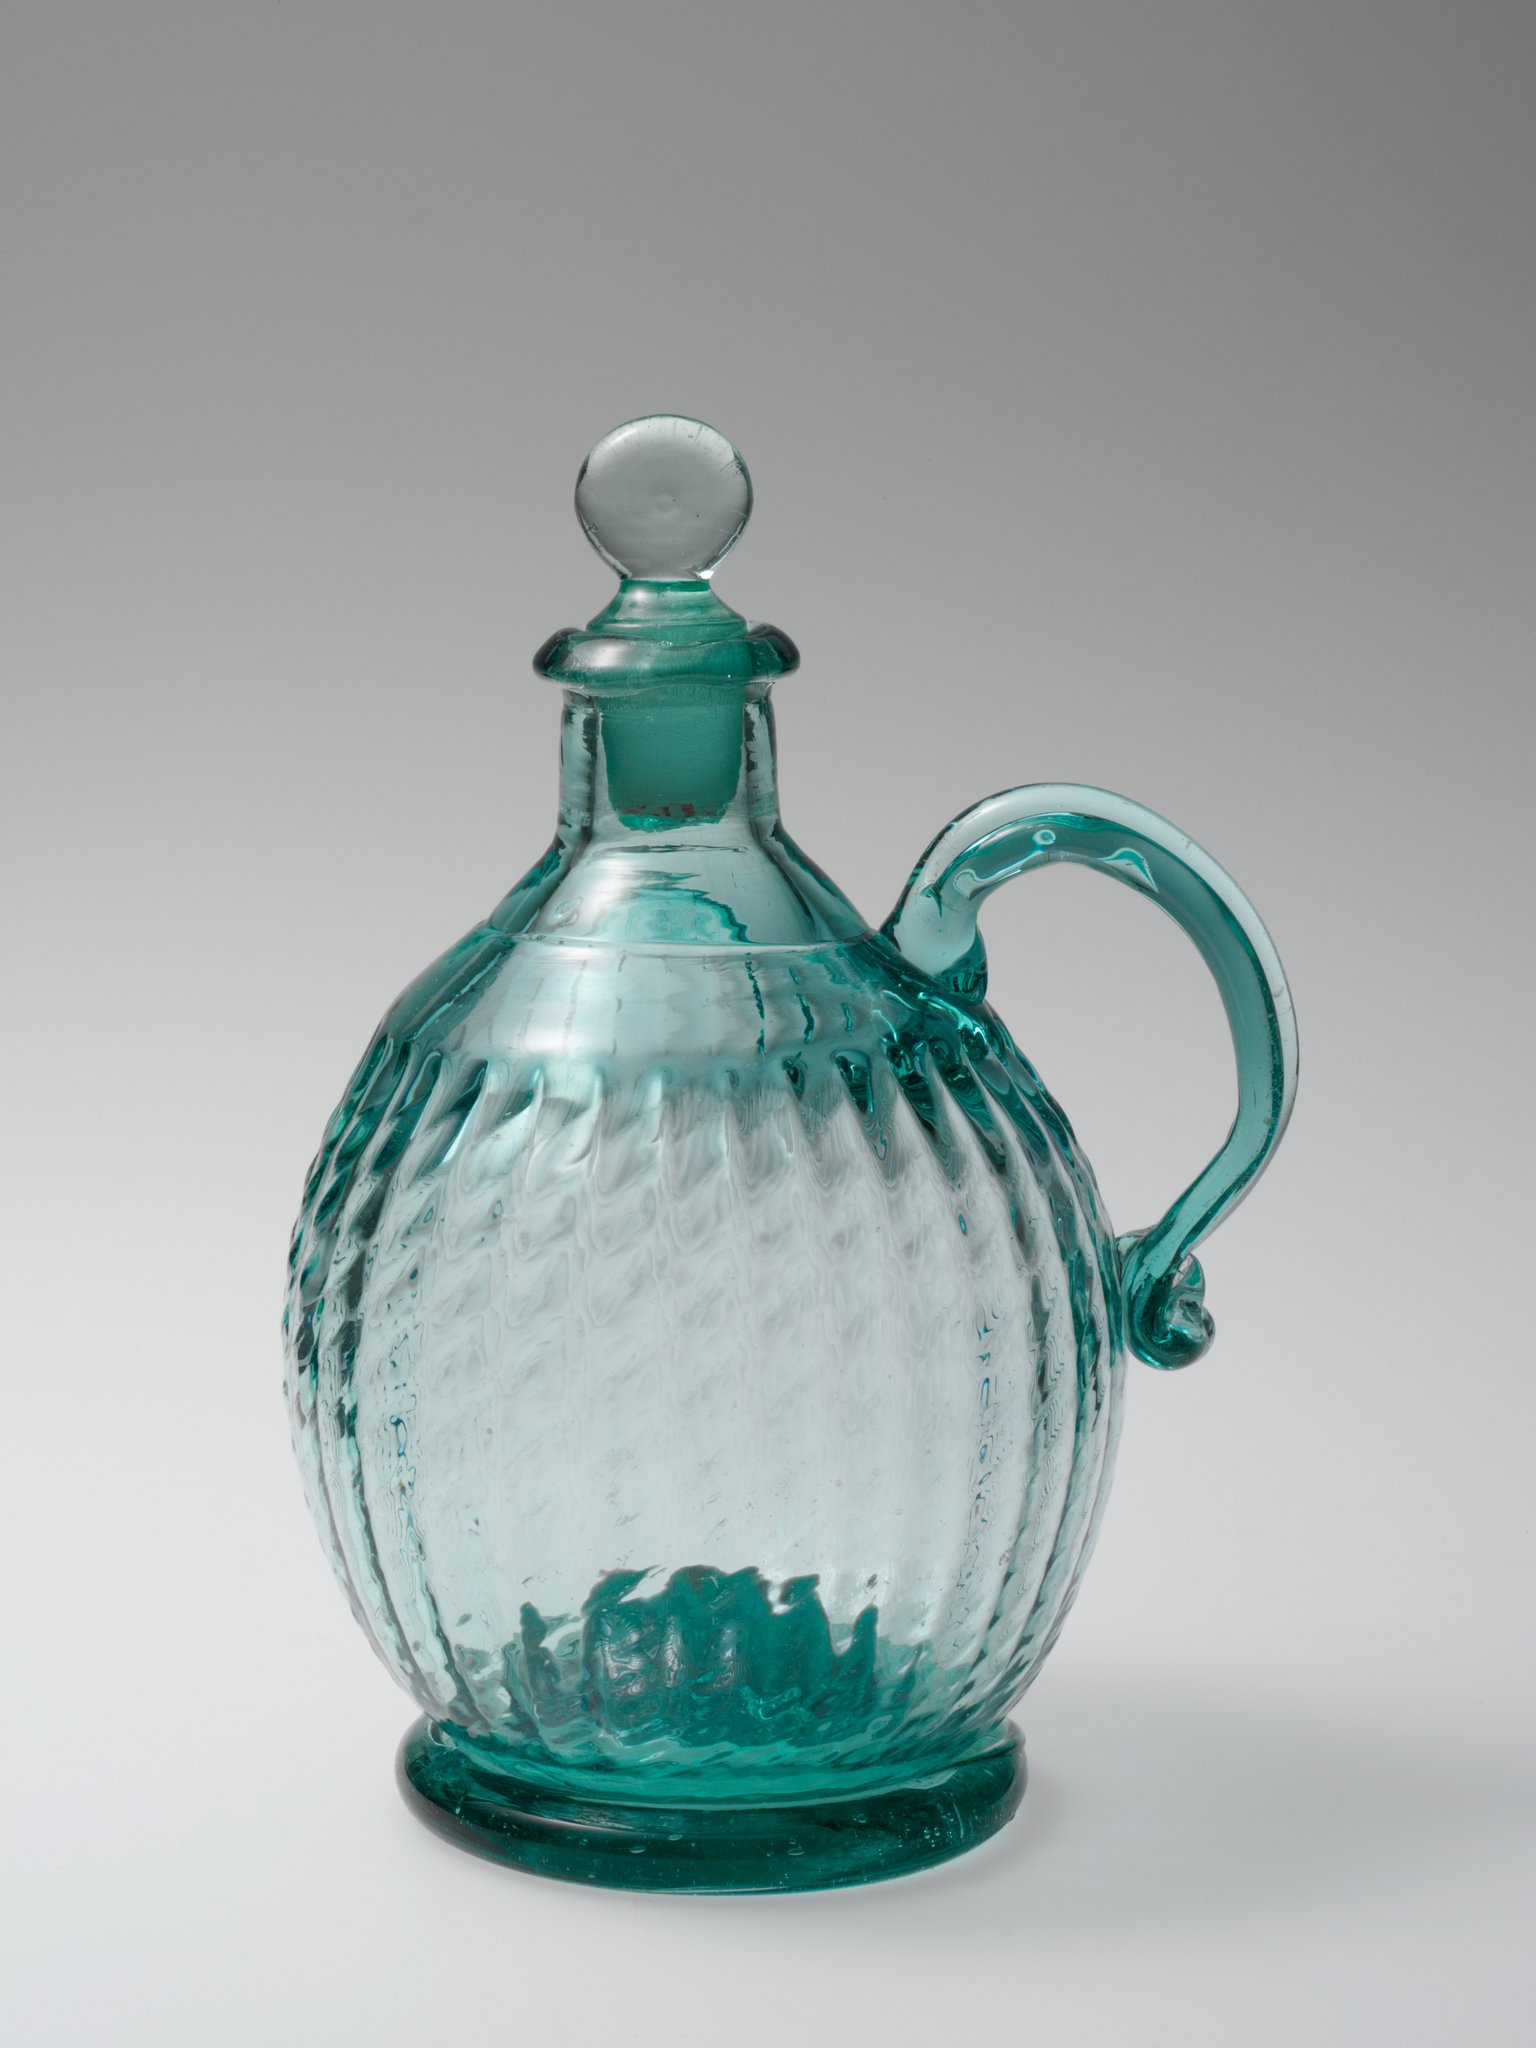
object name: cruet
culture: american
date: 1815-1845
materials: glass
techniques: glassblowing, molding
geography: united states